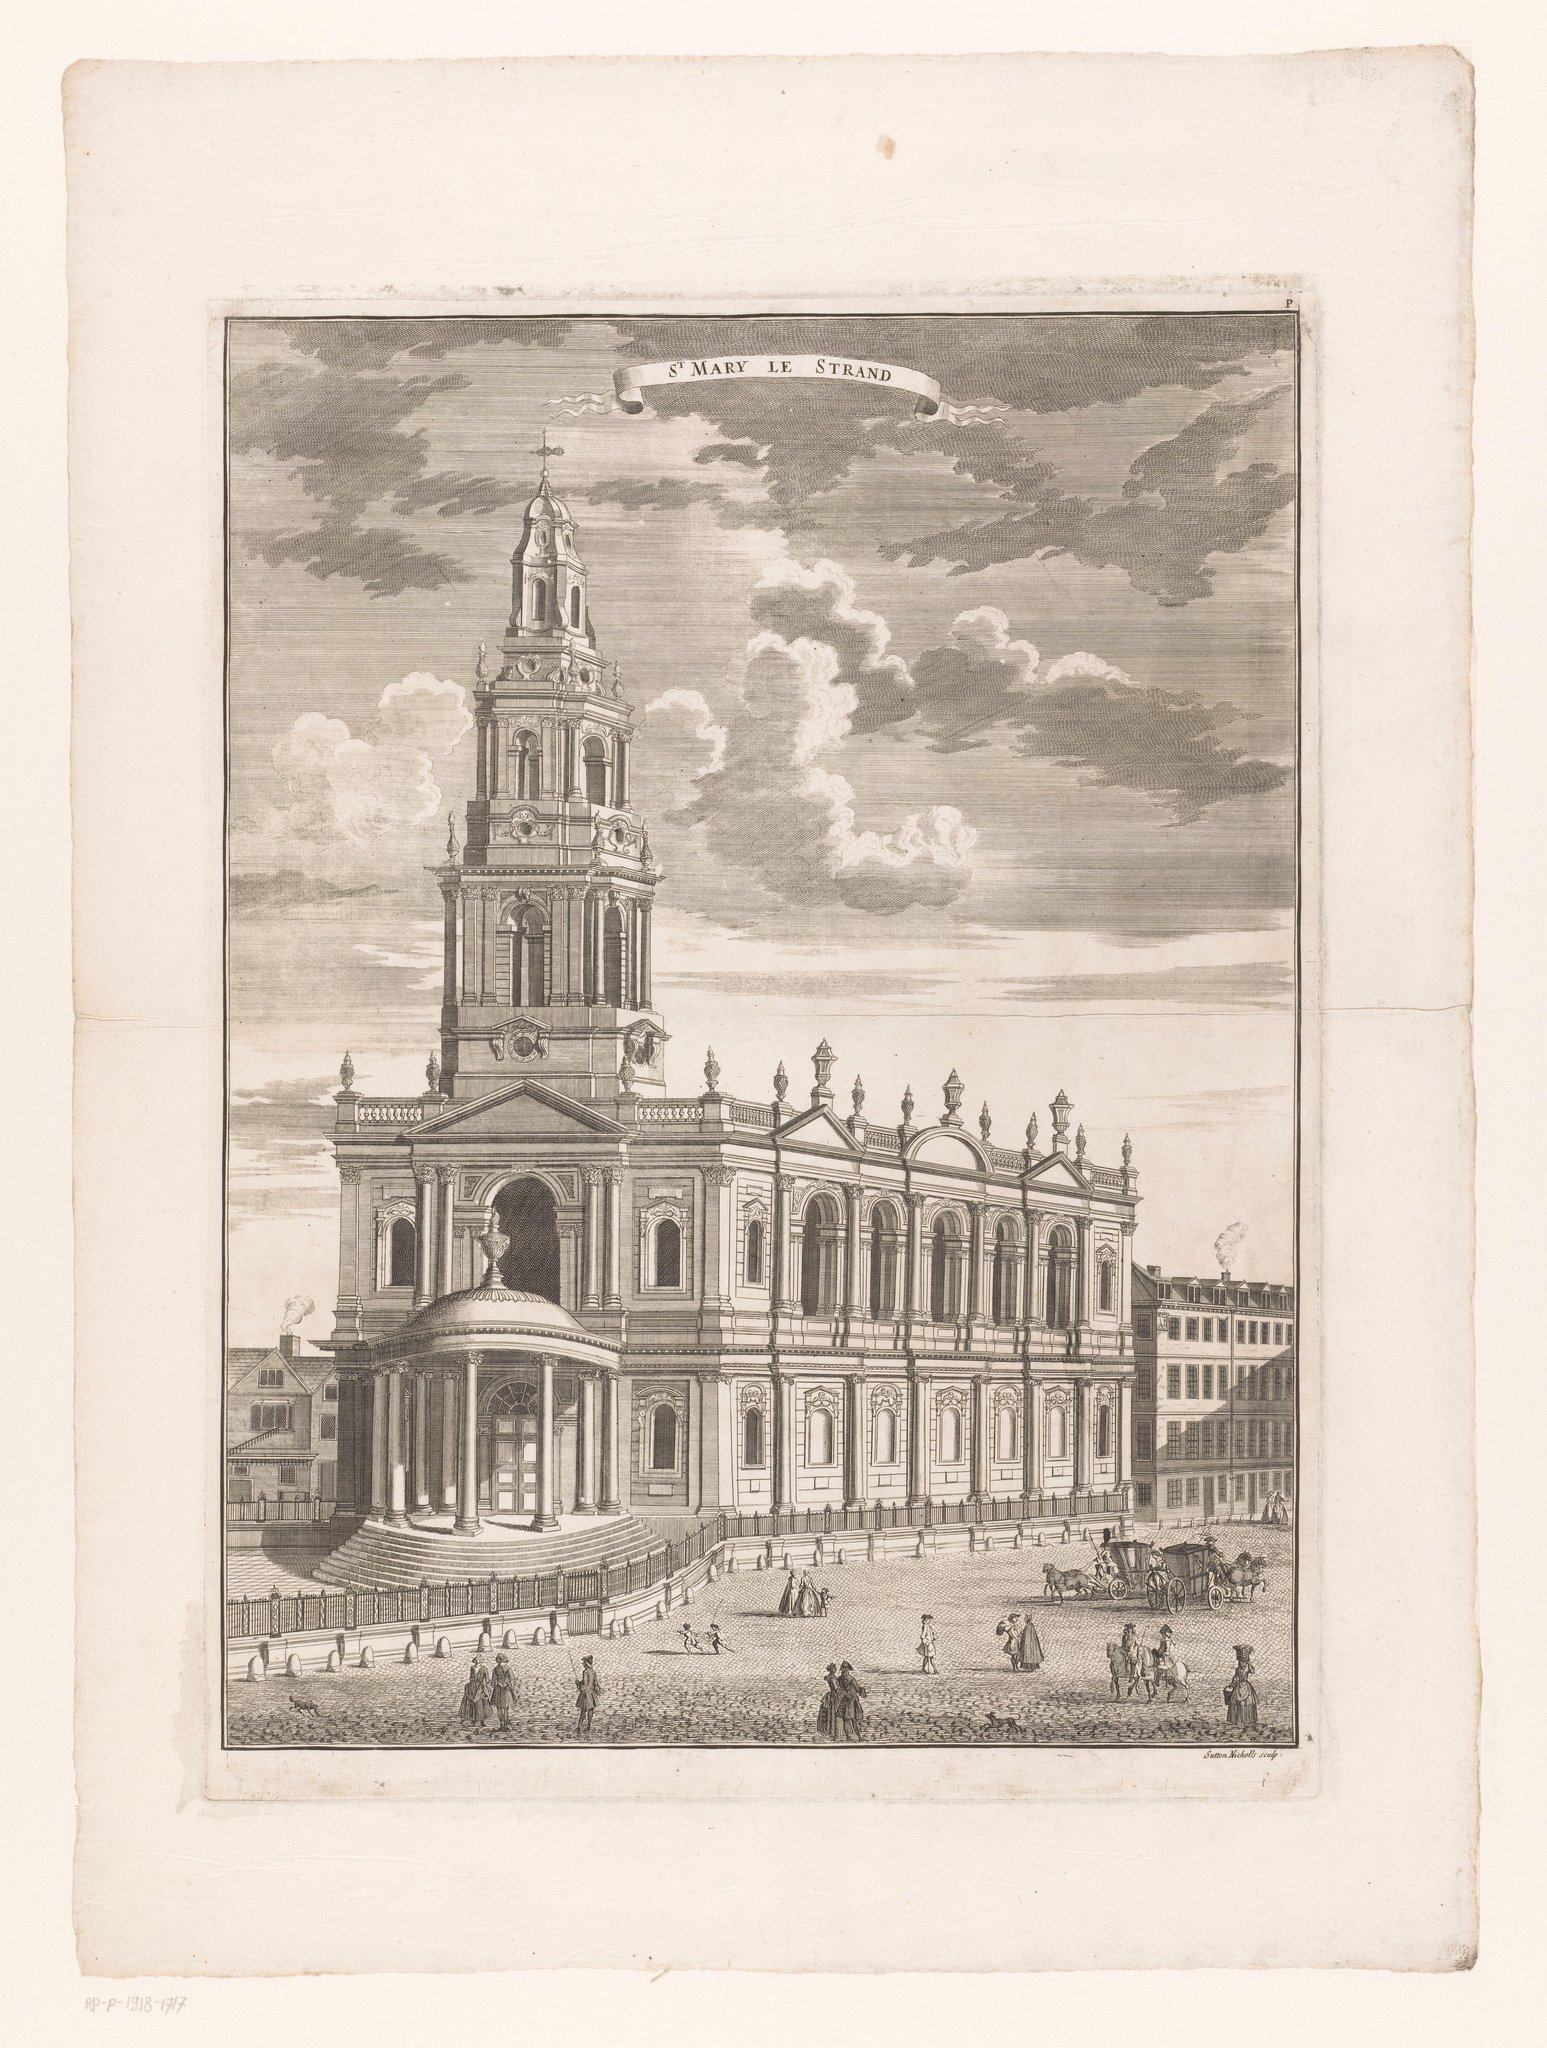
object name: print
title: Gezichten op gebouwen in Londen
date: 1720-1731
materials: paper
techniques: engraving, etching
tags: church (exterior), city-view in general; 'veduta' (+ city(-scape) with figures, staffage), london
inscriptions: collector's mark: Lugt 2233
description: Deze reeks werd voor het eerst compleet uitgegeven in 1731, al zijn de losse prenten al voor die tijd uitgebracht. De meeste prenten zijn vervaardigd door Sutton Nicholls. De serie werd aangeboden voor verkoop door John Bowles in zijn catalogus 1753, op pagina 76, nummer 16.